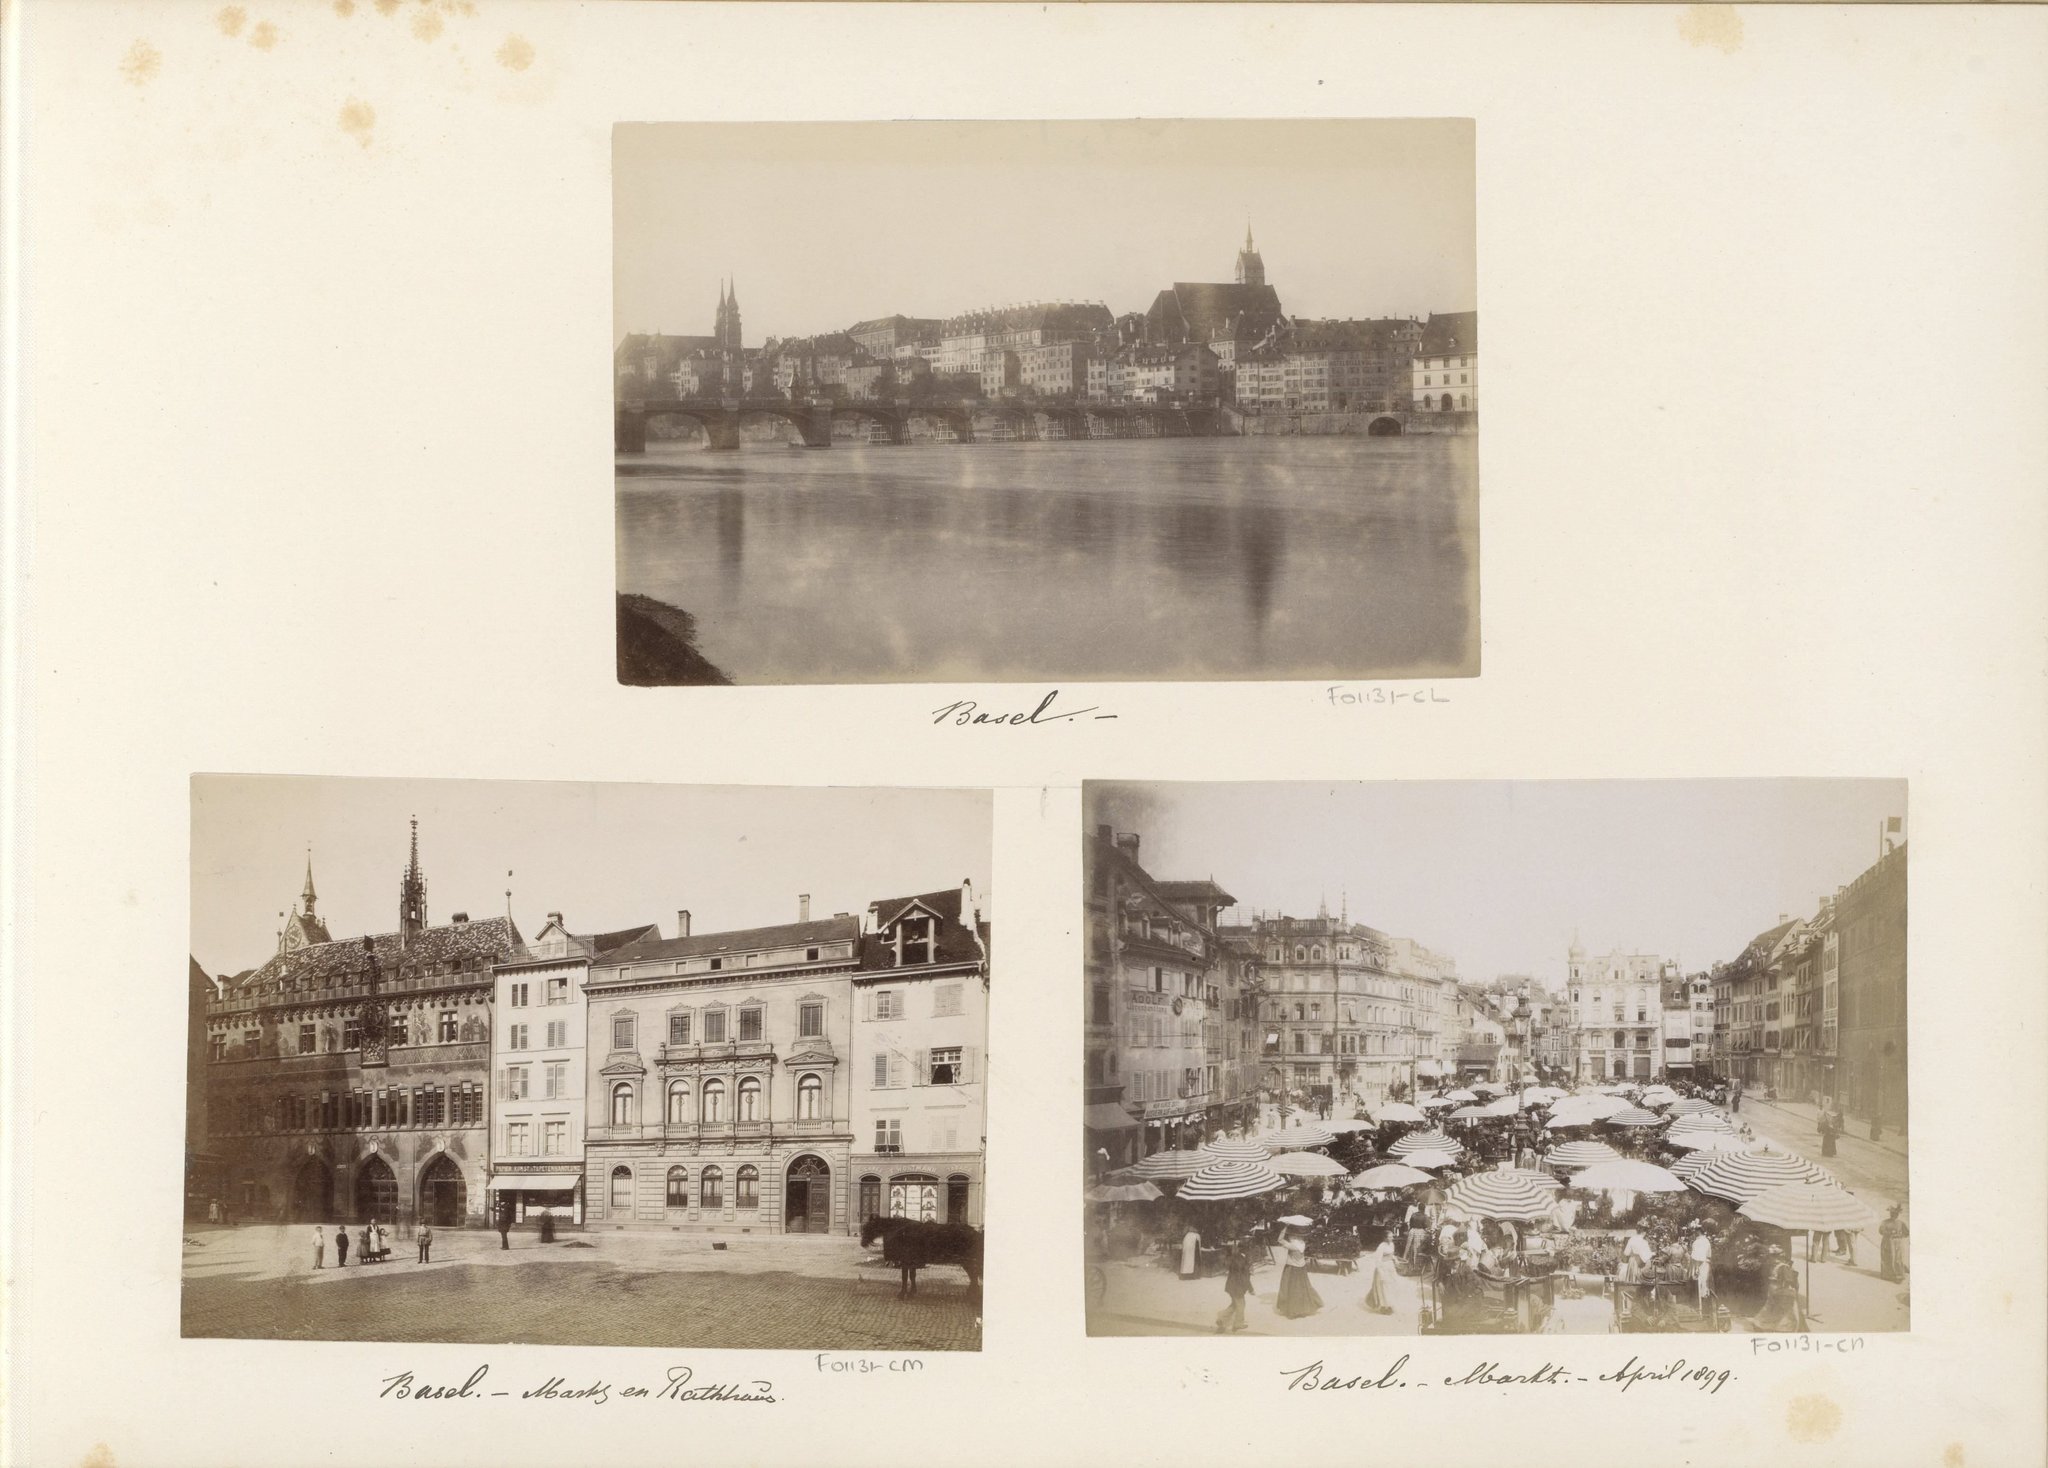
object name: photograph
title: Markt met stallen onder parasols in Bazel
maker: Anonymous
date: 1880-1899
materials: paper, photographic support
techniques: albumen print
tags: stall, booth (~ market), market, parasol, sunshade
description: Onderdeel van Reisalbum met bezienswaardigheden in Duitsland, Oostenrijk, Zwitserland, Luxemburg en België.